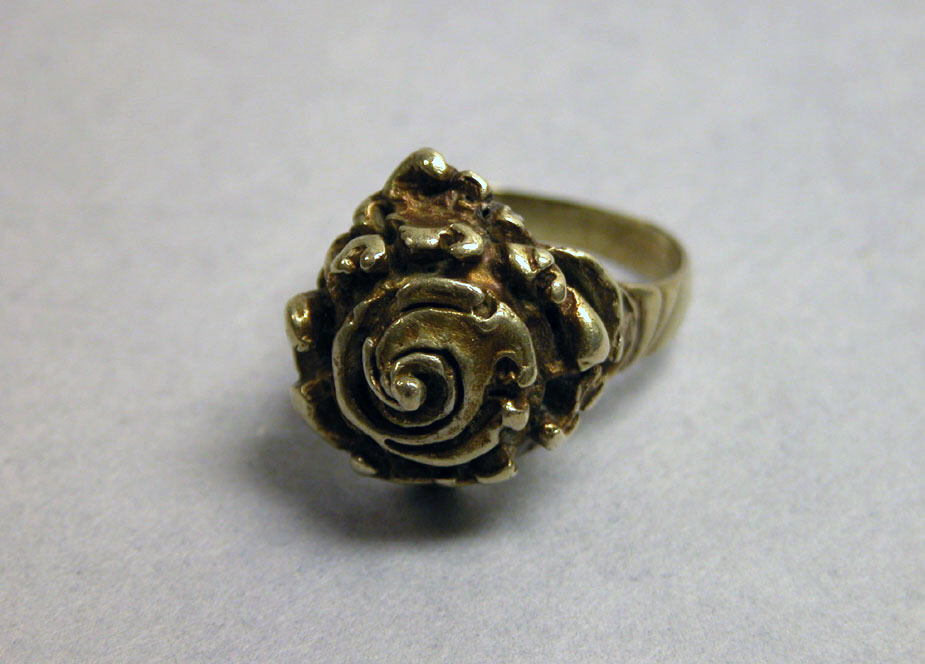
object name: ring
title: Ring with Round Bezel depicting Sekti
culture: indonesian, javanese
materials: gold